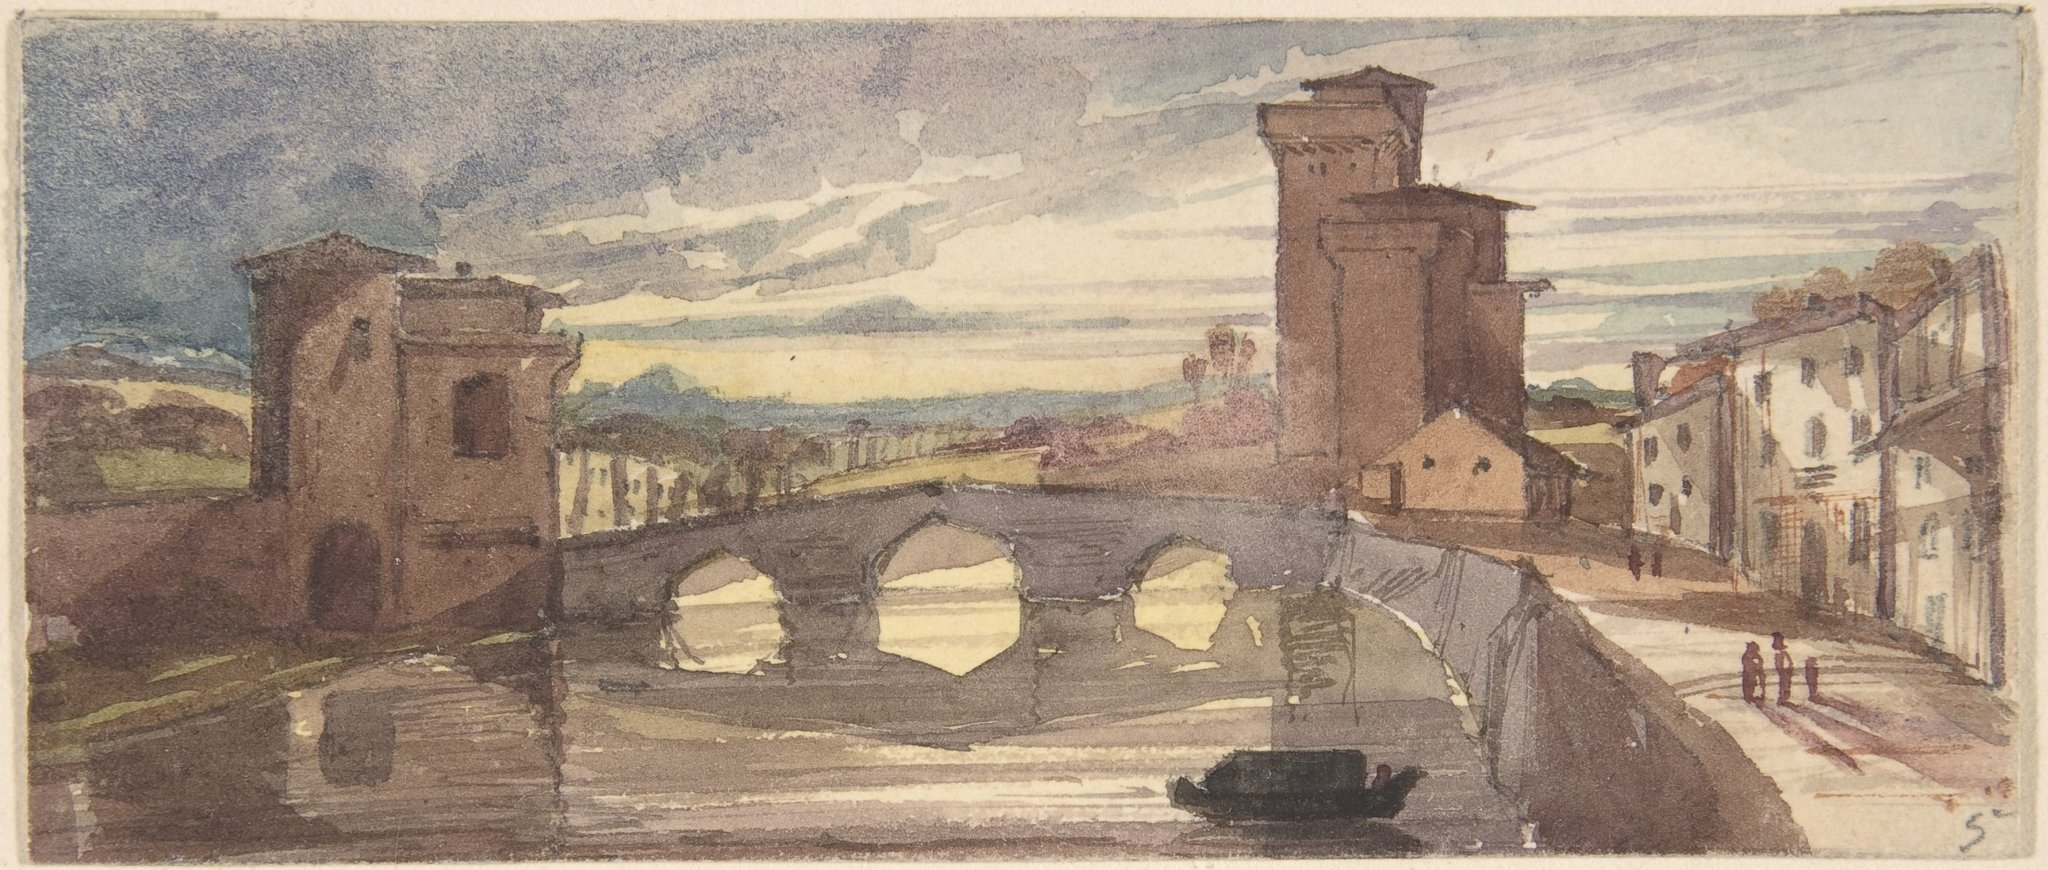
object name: drawing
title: Pisa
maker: francis seymour haden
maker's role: artist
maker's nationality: british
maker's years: 1818-1910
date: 1843-1844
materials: graphite, watercolor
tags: buildings,bridges,boats